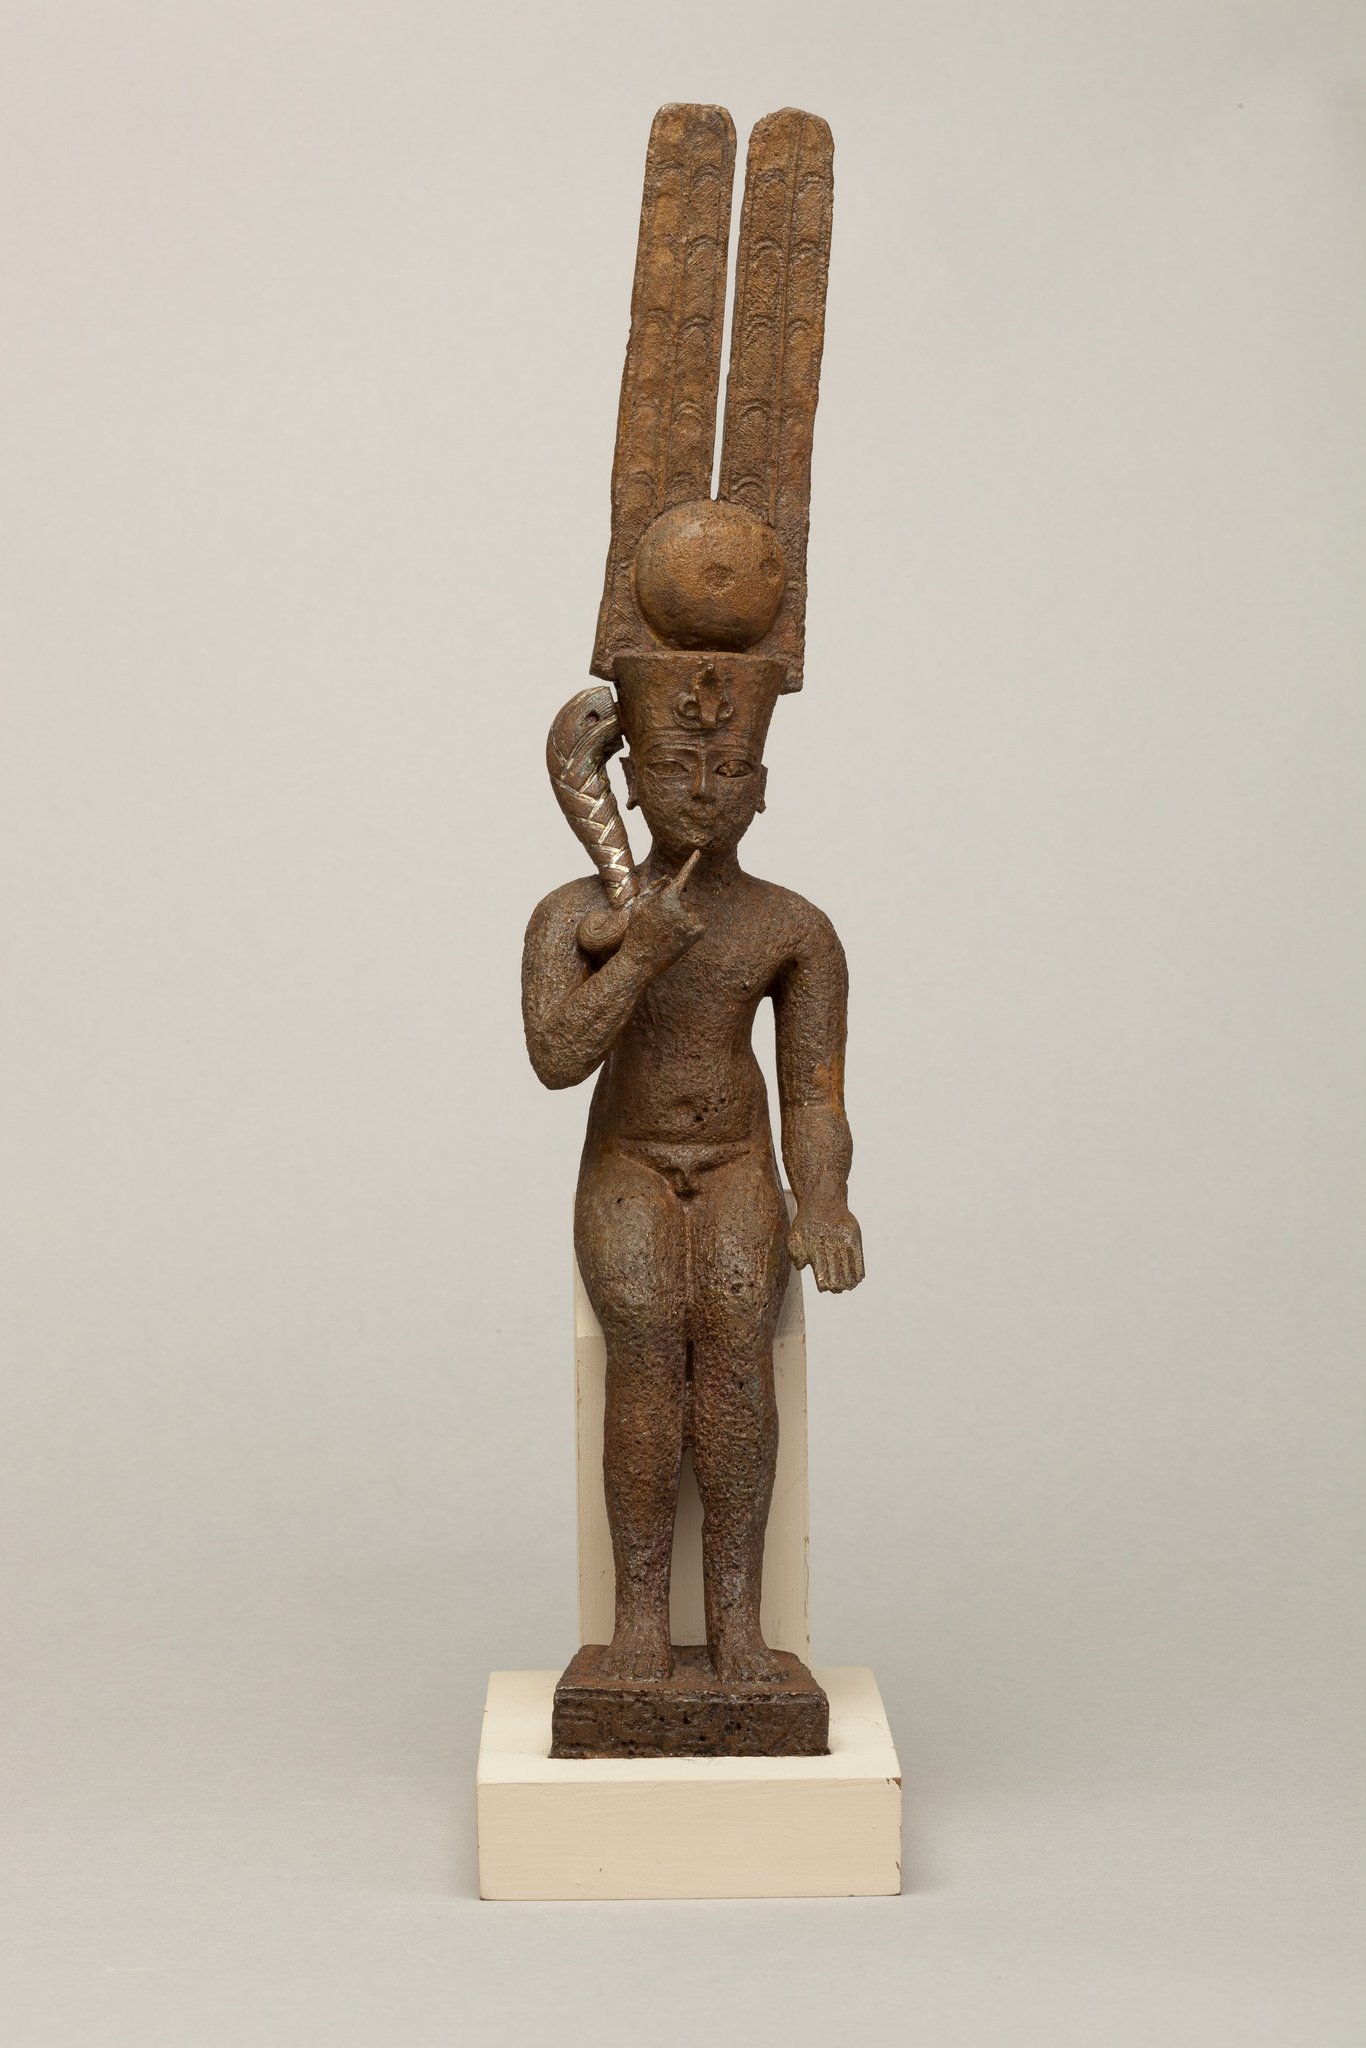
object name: statue, harpokrates, seated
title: Seated Harpokrates with the crown of Amun, named as "Harpokrates-the-great, the eldest, the first of Amun"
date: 664-630 BCE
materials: metal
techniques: inlay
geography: egypt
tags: amun